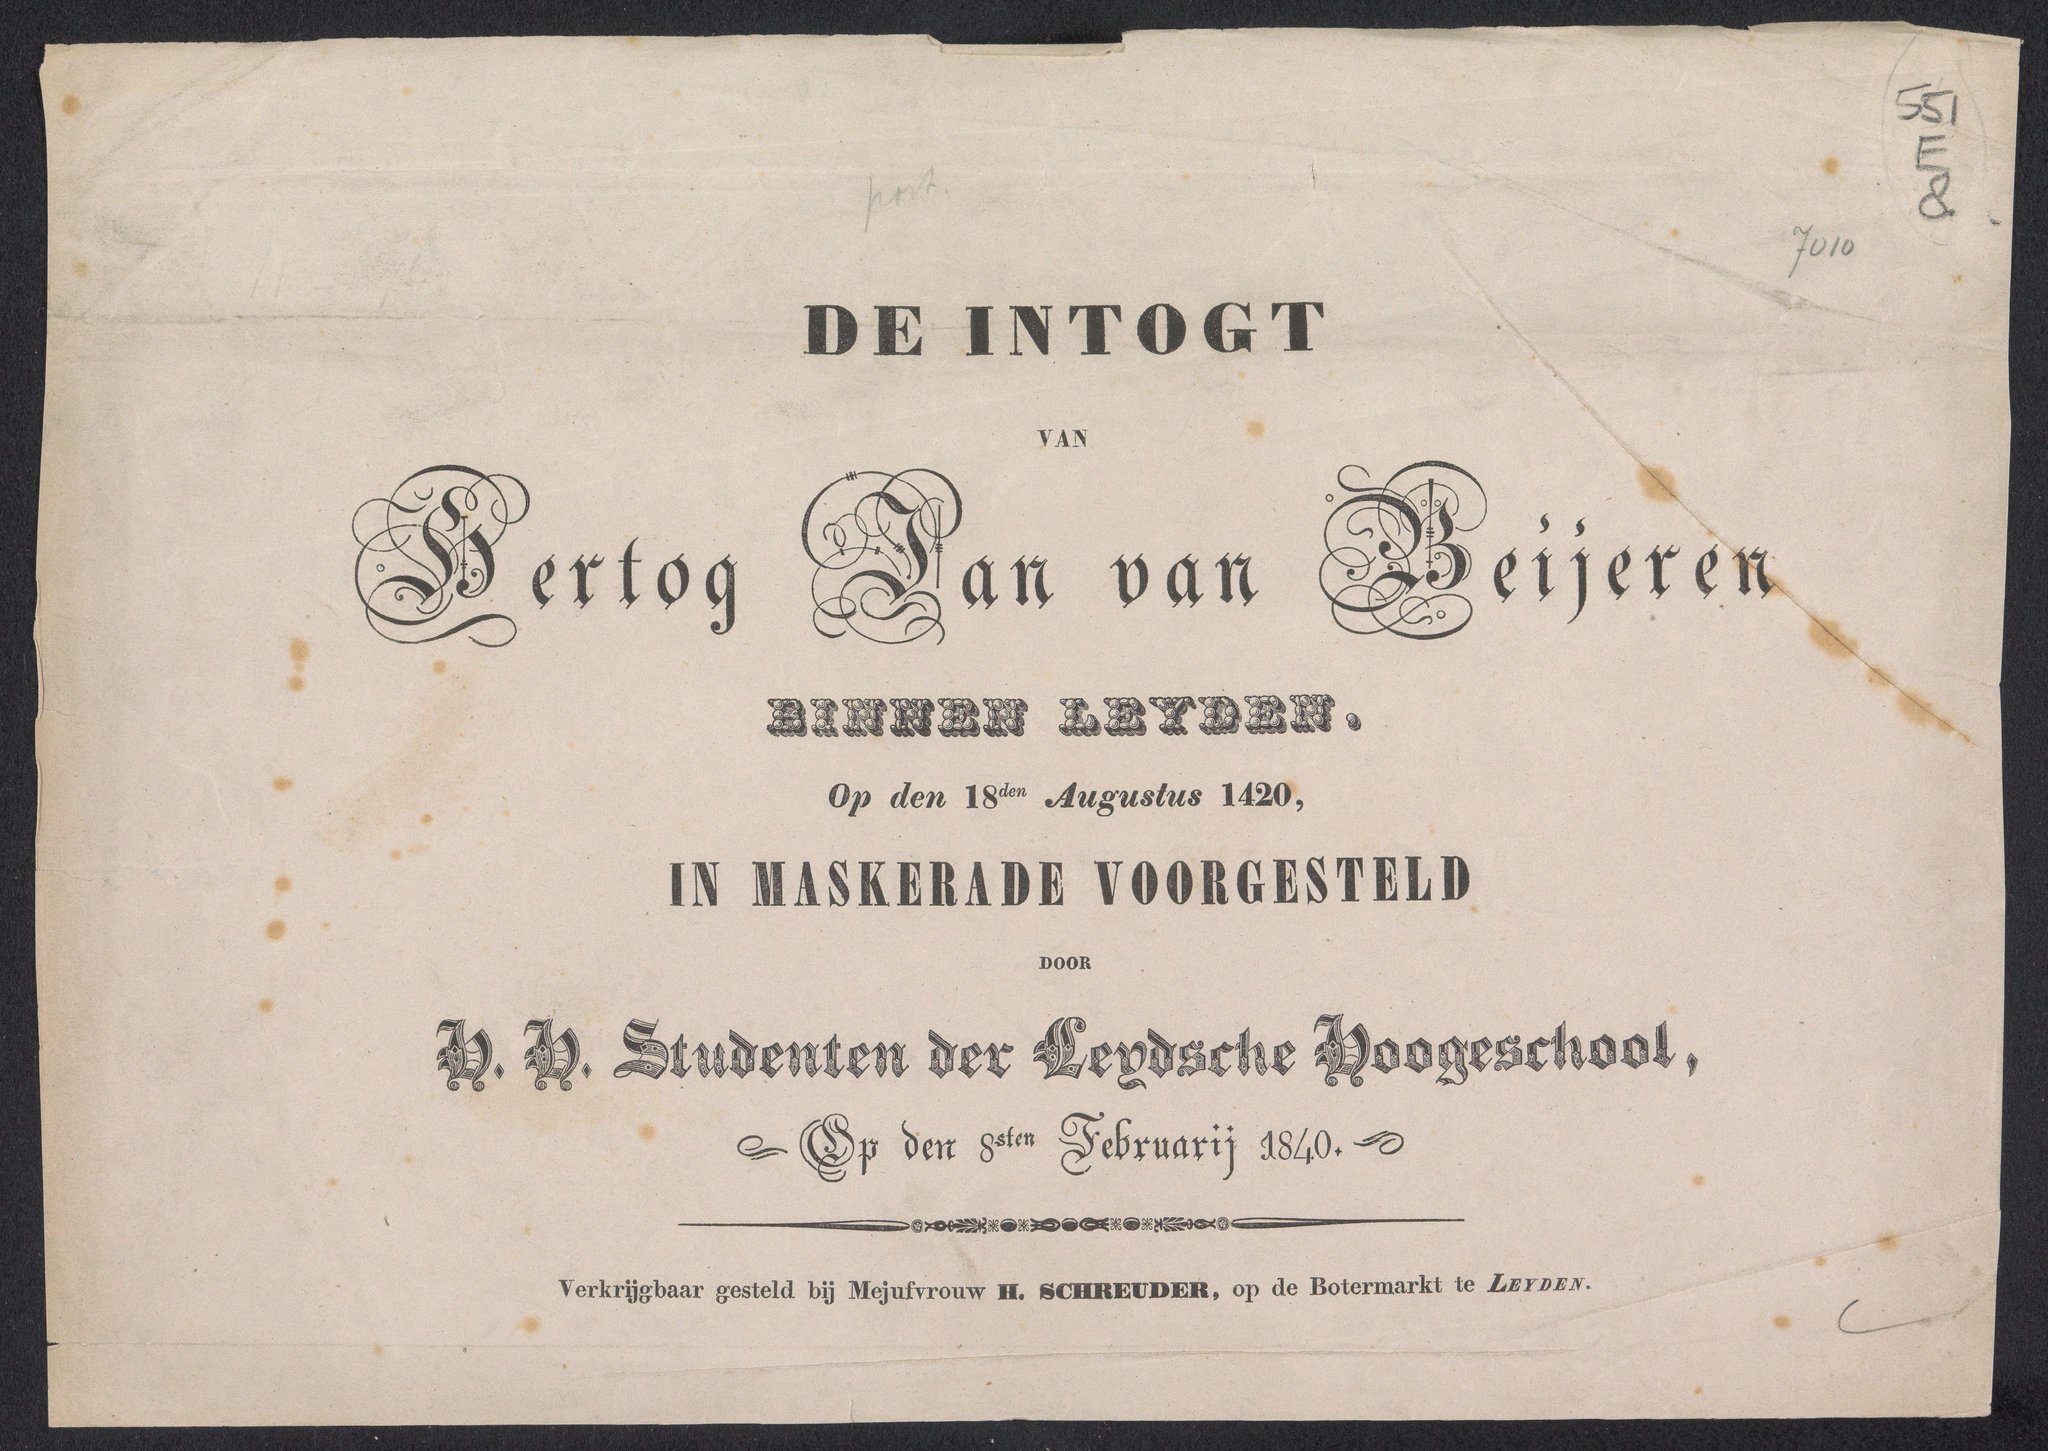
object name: titelblad, titelpagina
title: Maskerade door studenten van de Leidse Hogeschool, 1840 (titelblad)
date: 1840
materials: paper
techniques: letterpress printing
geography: leiden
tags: jan van beieren, students' pageant, costumes used in pageants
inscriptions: collector's mark: ‘Bibliotheek Rijksmuseum Amsterdam’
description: Historische gekostumeerde optocht van de studenten van de Hogeschool van Leiden op 8 februari 1840. De optocht verbeeldt de intocht van hertog Jan van Beieren te Leiden op 18 augustus 1420. Typografisch titelblad voor de serie van negentien ongenummerde platen.